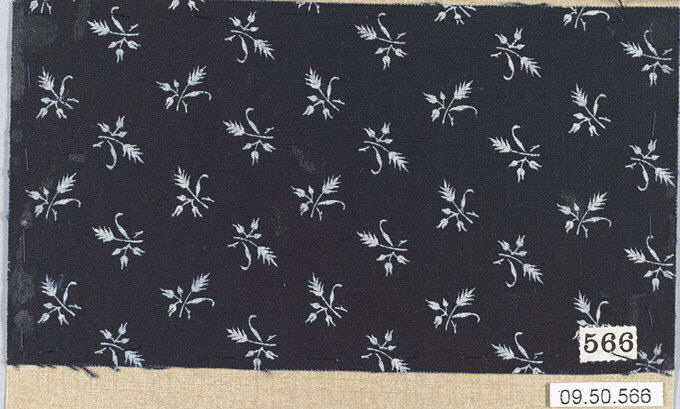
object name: piece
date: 1801-1900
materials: cotton